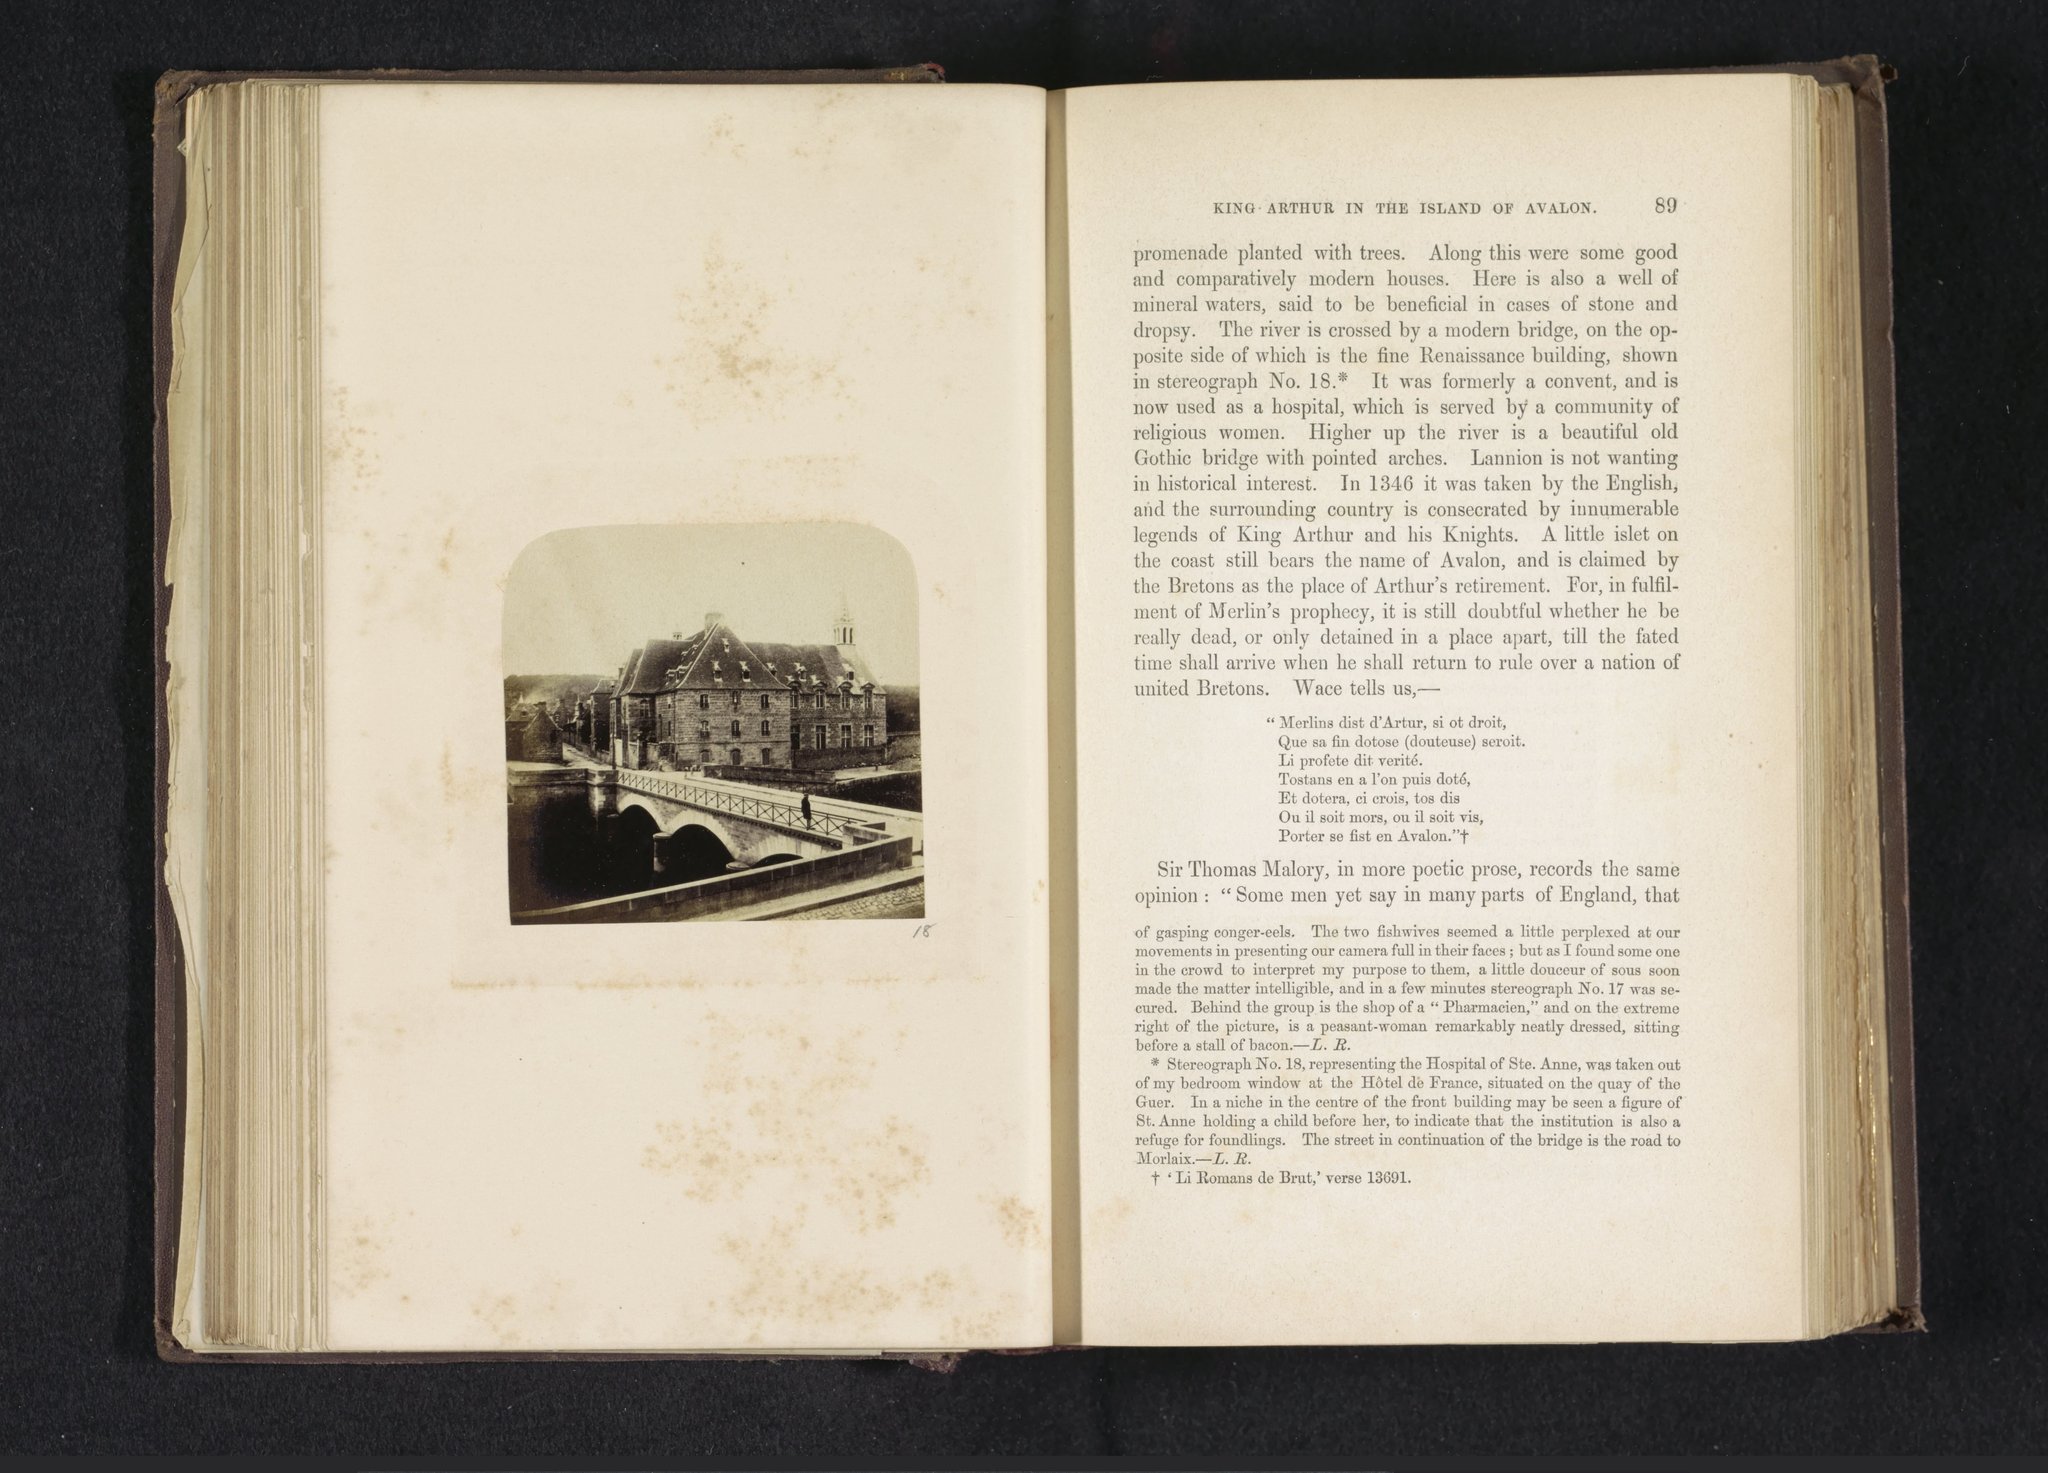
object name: page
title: Ziekenhuis St. Anne in Lannion met op de voorgrond een brug over de Guer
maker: taylor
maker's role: fotograaf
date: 1850-1859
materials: photographic support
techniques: albumen print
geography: lannion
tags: hospital, bridge in village across river, canal, etc.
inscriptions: number: ‘18’